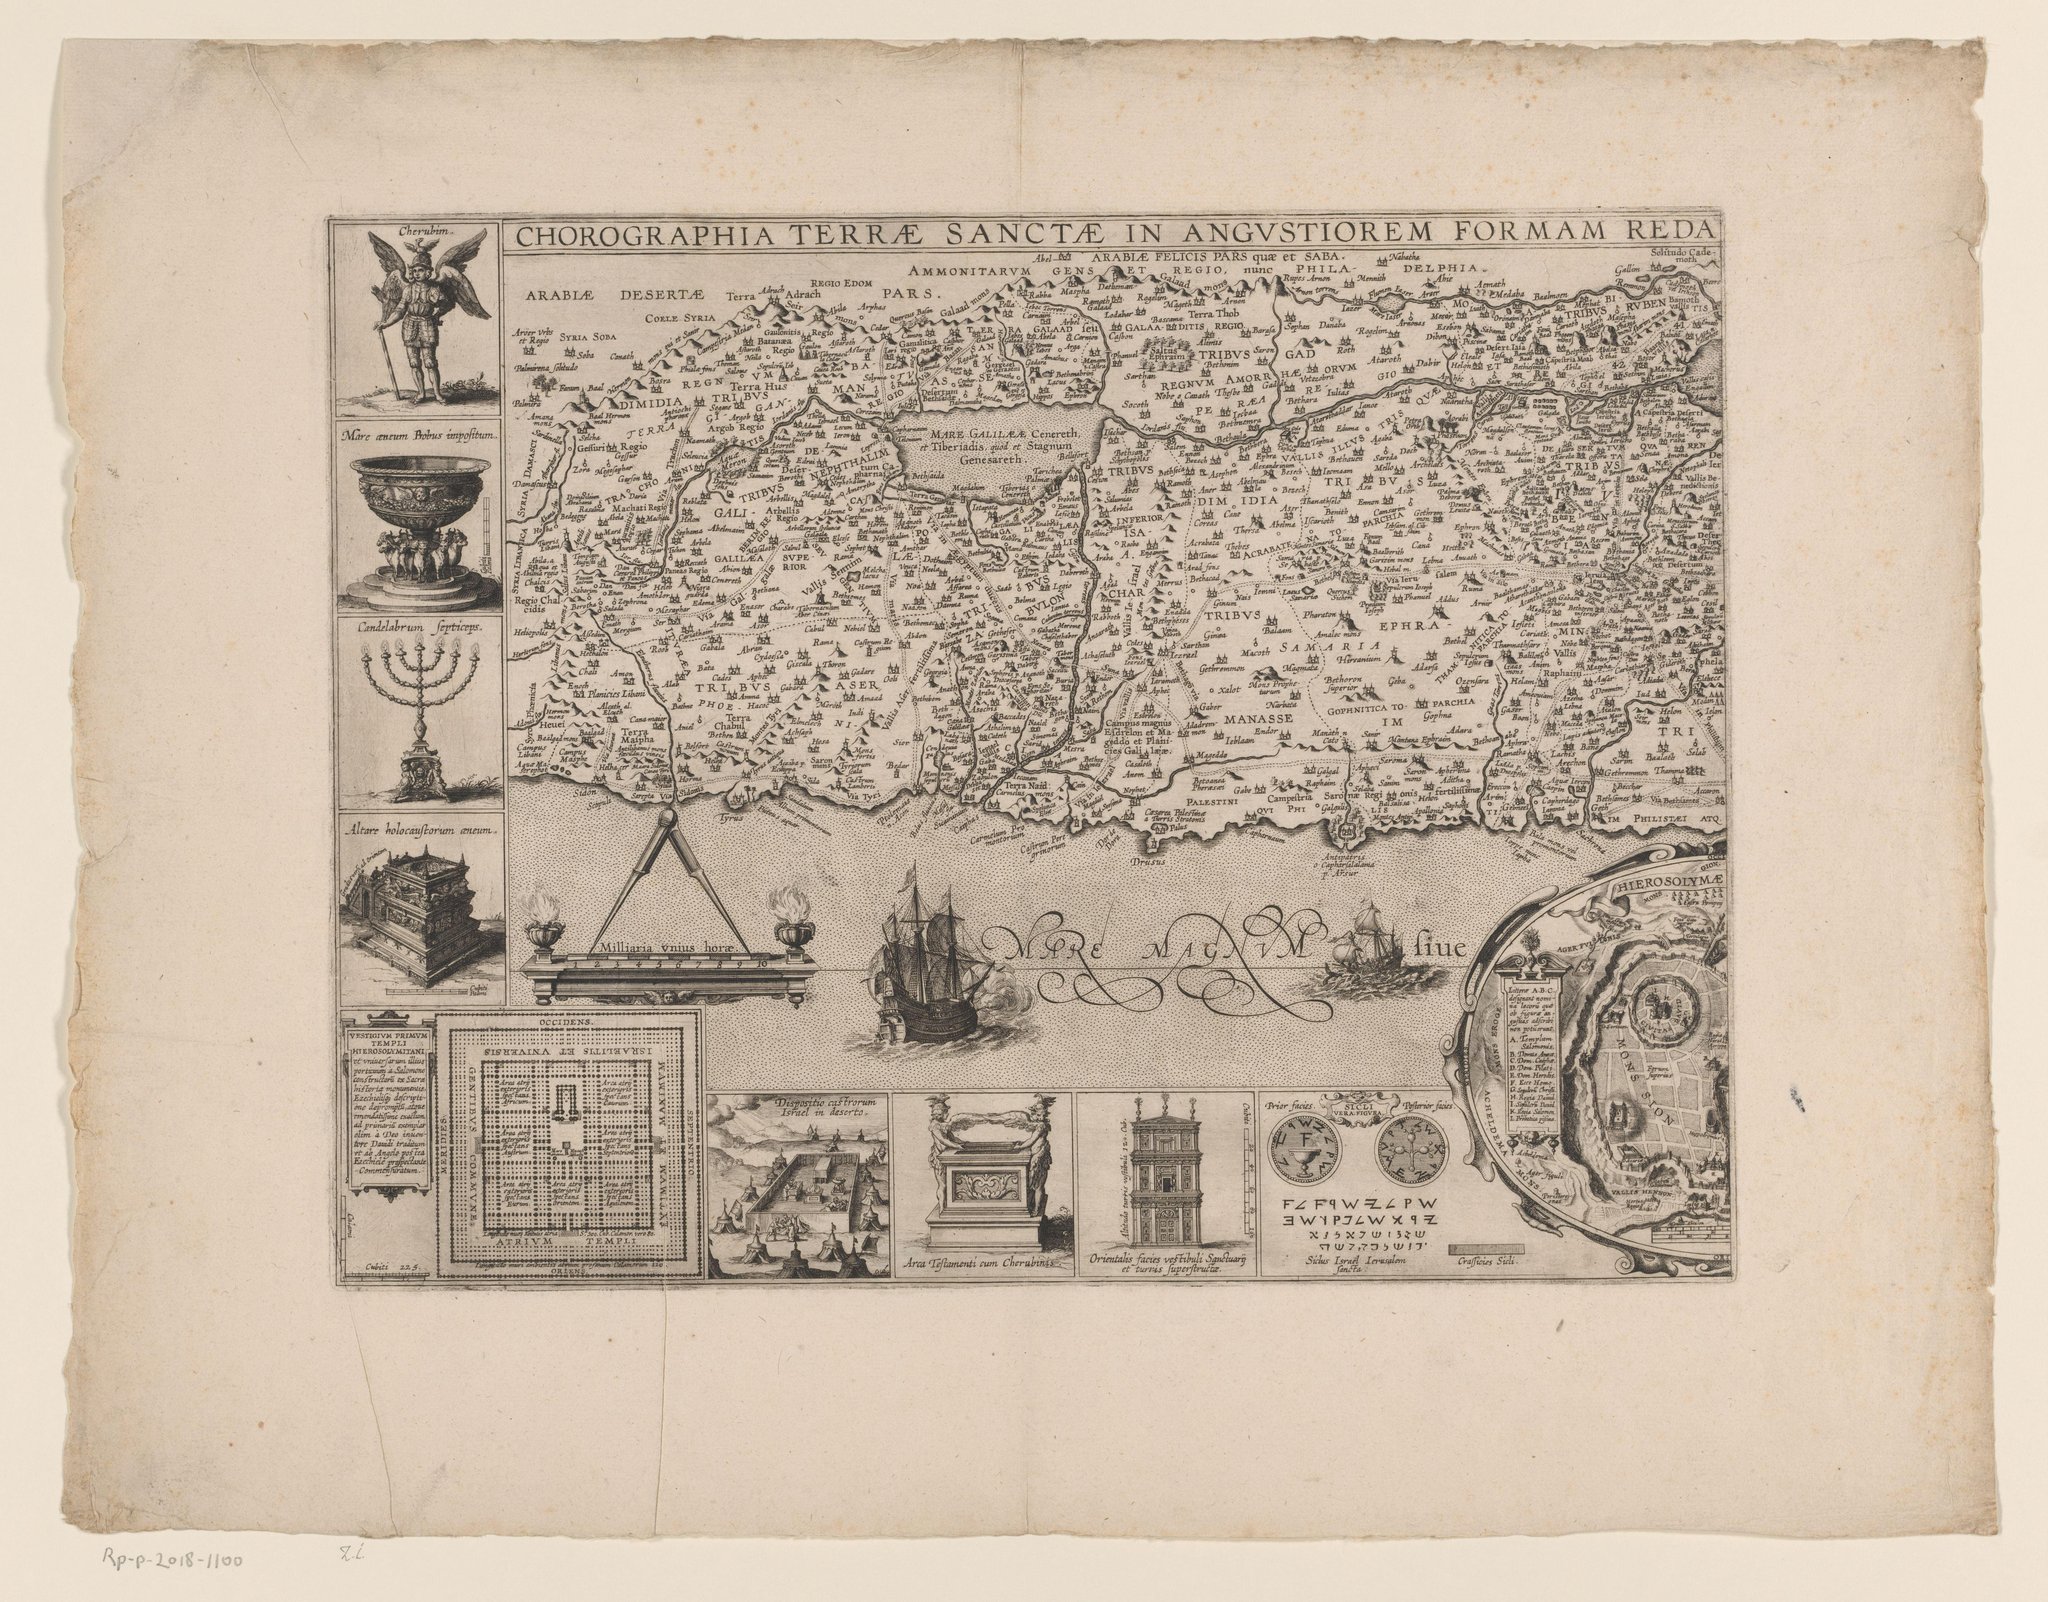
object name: area plan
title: Chorographia Terrae Sanctae in angustiorem formam redacta, et ex variis auctoribus (...)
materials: paper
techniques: engraving, etching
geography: antwerp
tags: maps of separate countries or regions, the book exodus: story of moses and aaron, maps of cities, the temple (in general) ~ jewish religion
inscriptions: collector's mark: Lugt 2228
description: Prent ook gebruikt in: Tirinus, Jacobus. Commentarius in Vetus et Novum Testamentum. Antwerpen: Martiuns Nutius (III), 1632.